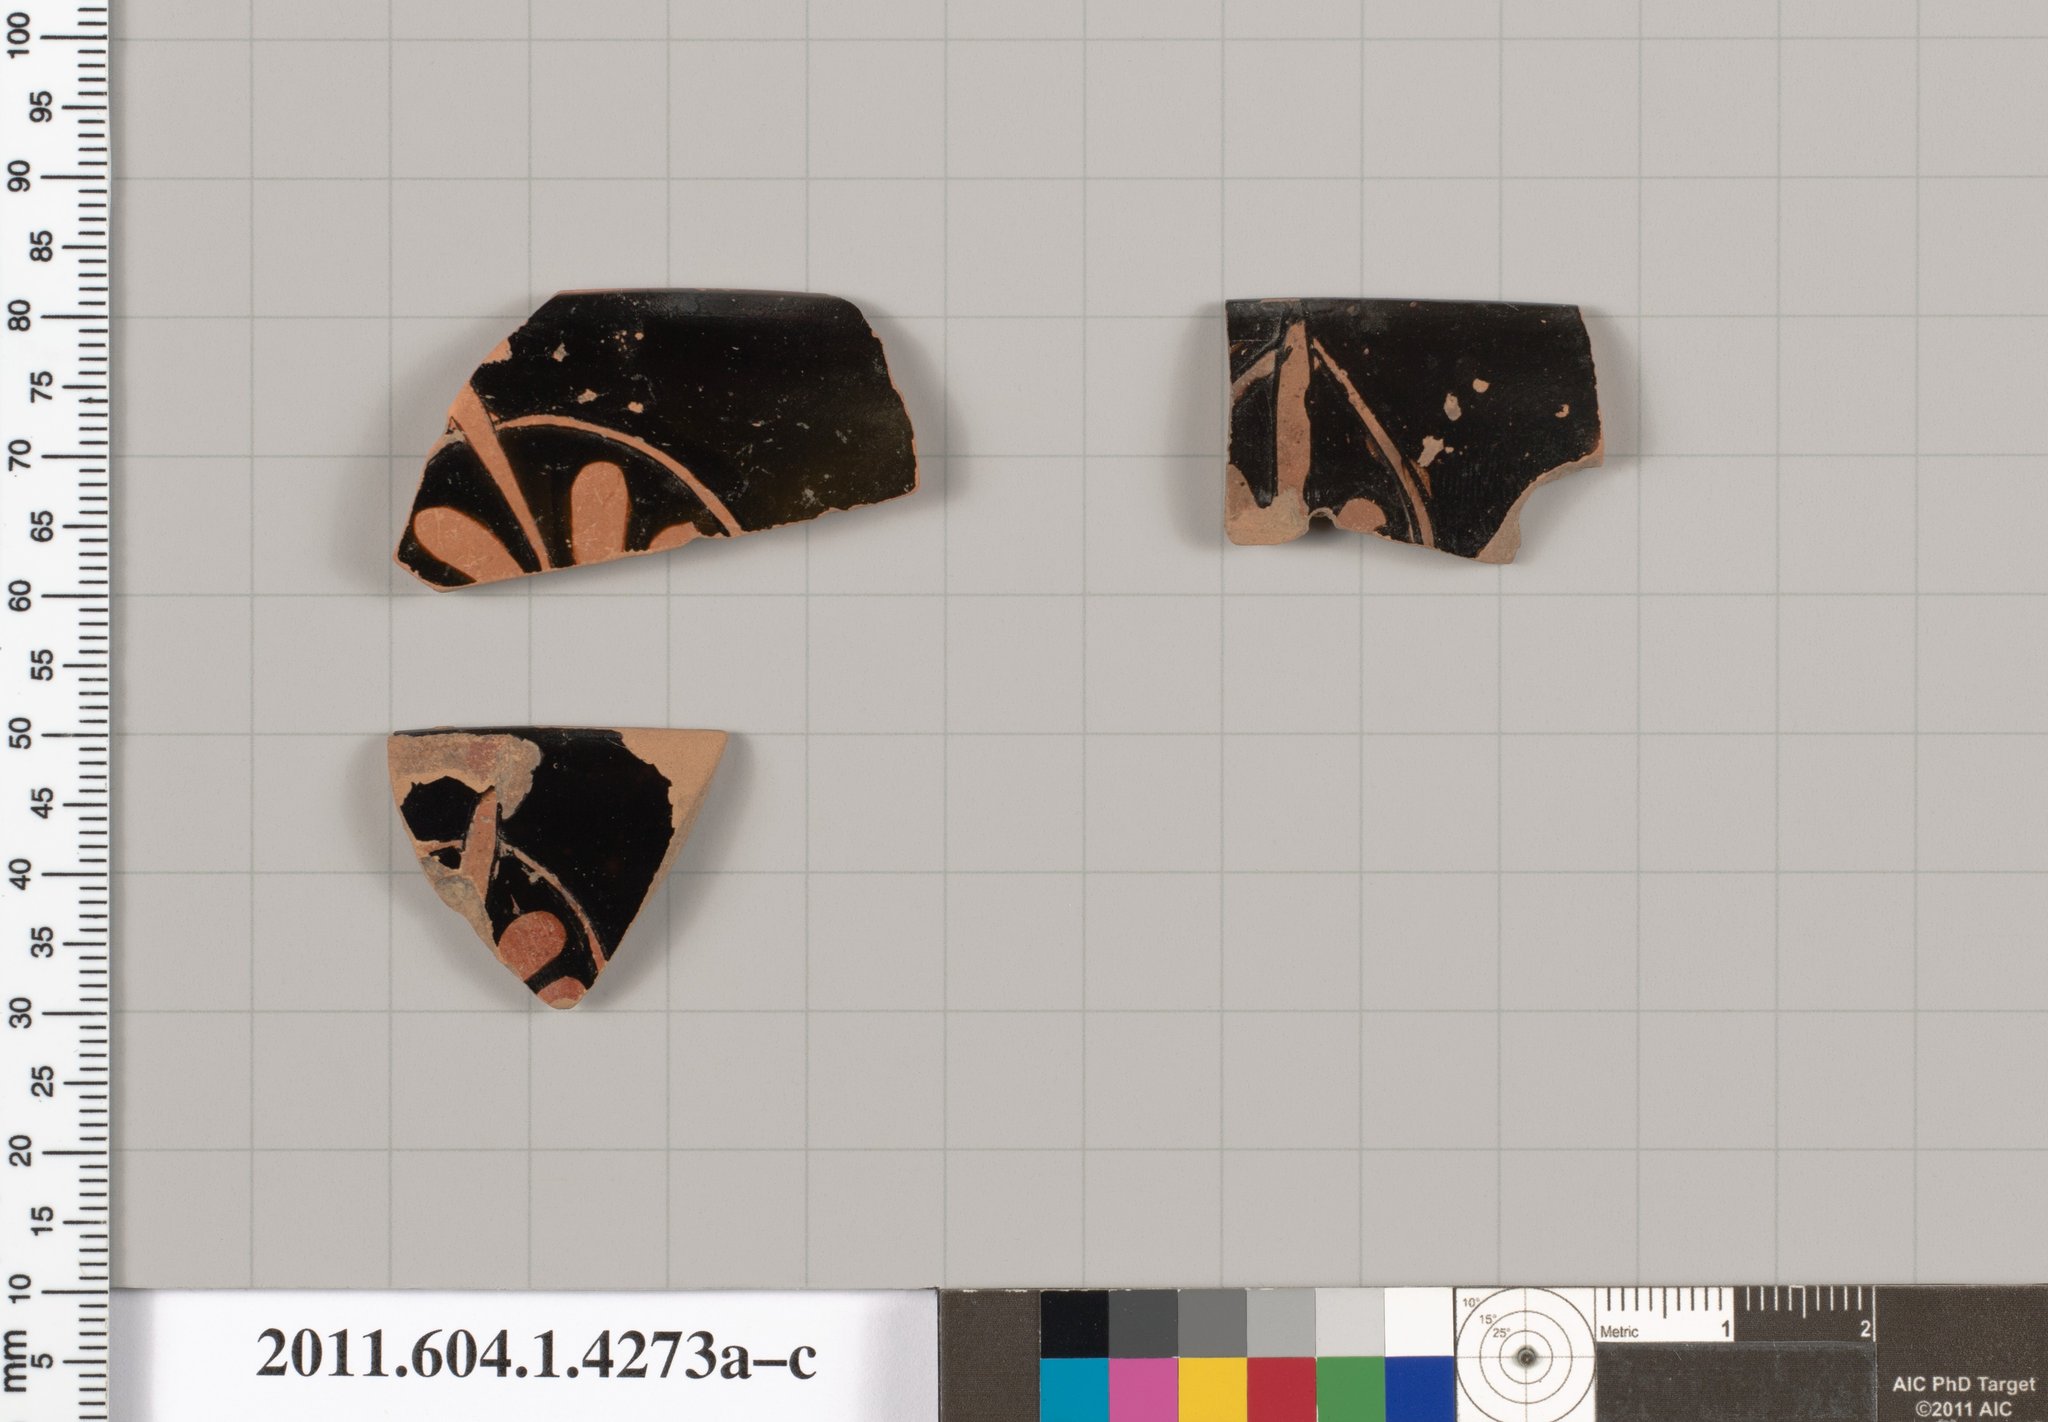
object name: kylix fragment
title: Terracotta rim fragments of kylikes (drinking cups)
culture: greek, attic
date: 500-470 BCE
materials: terracotta